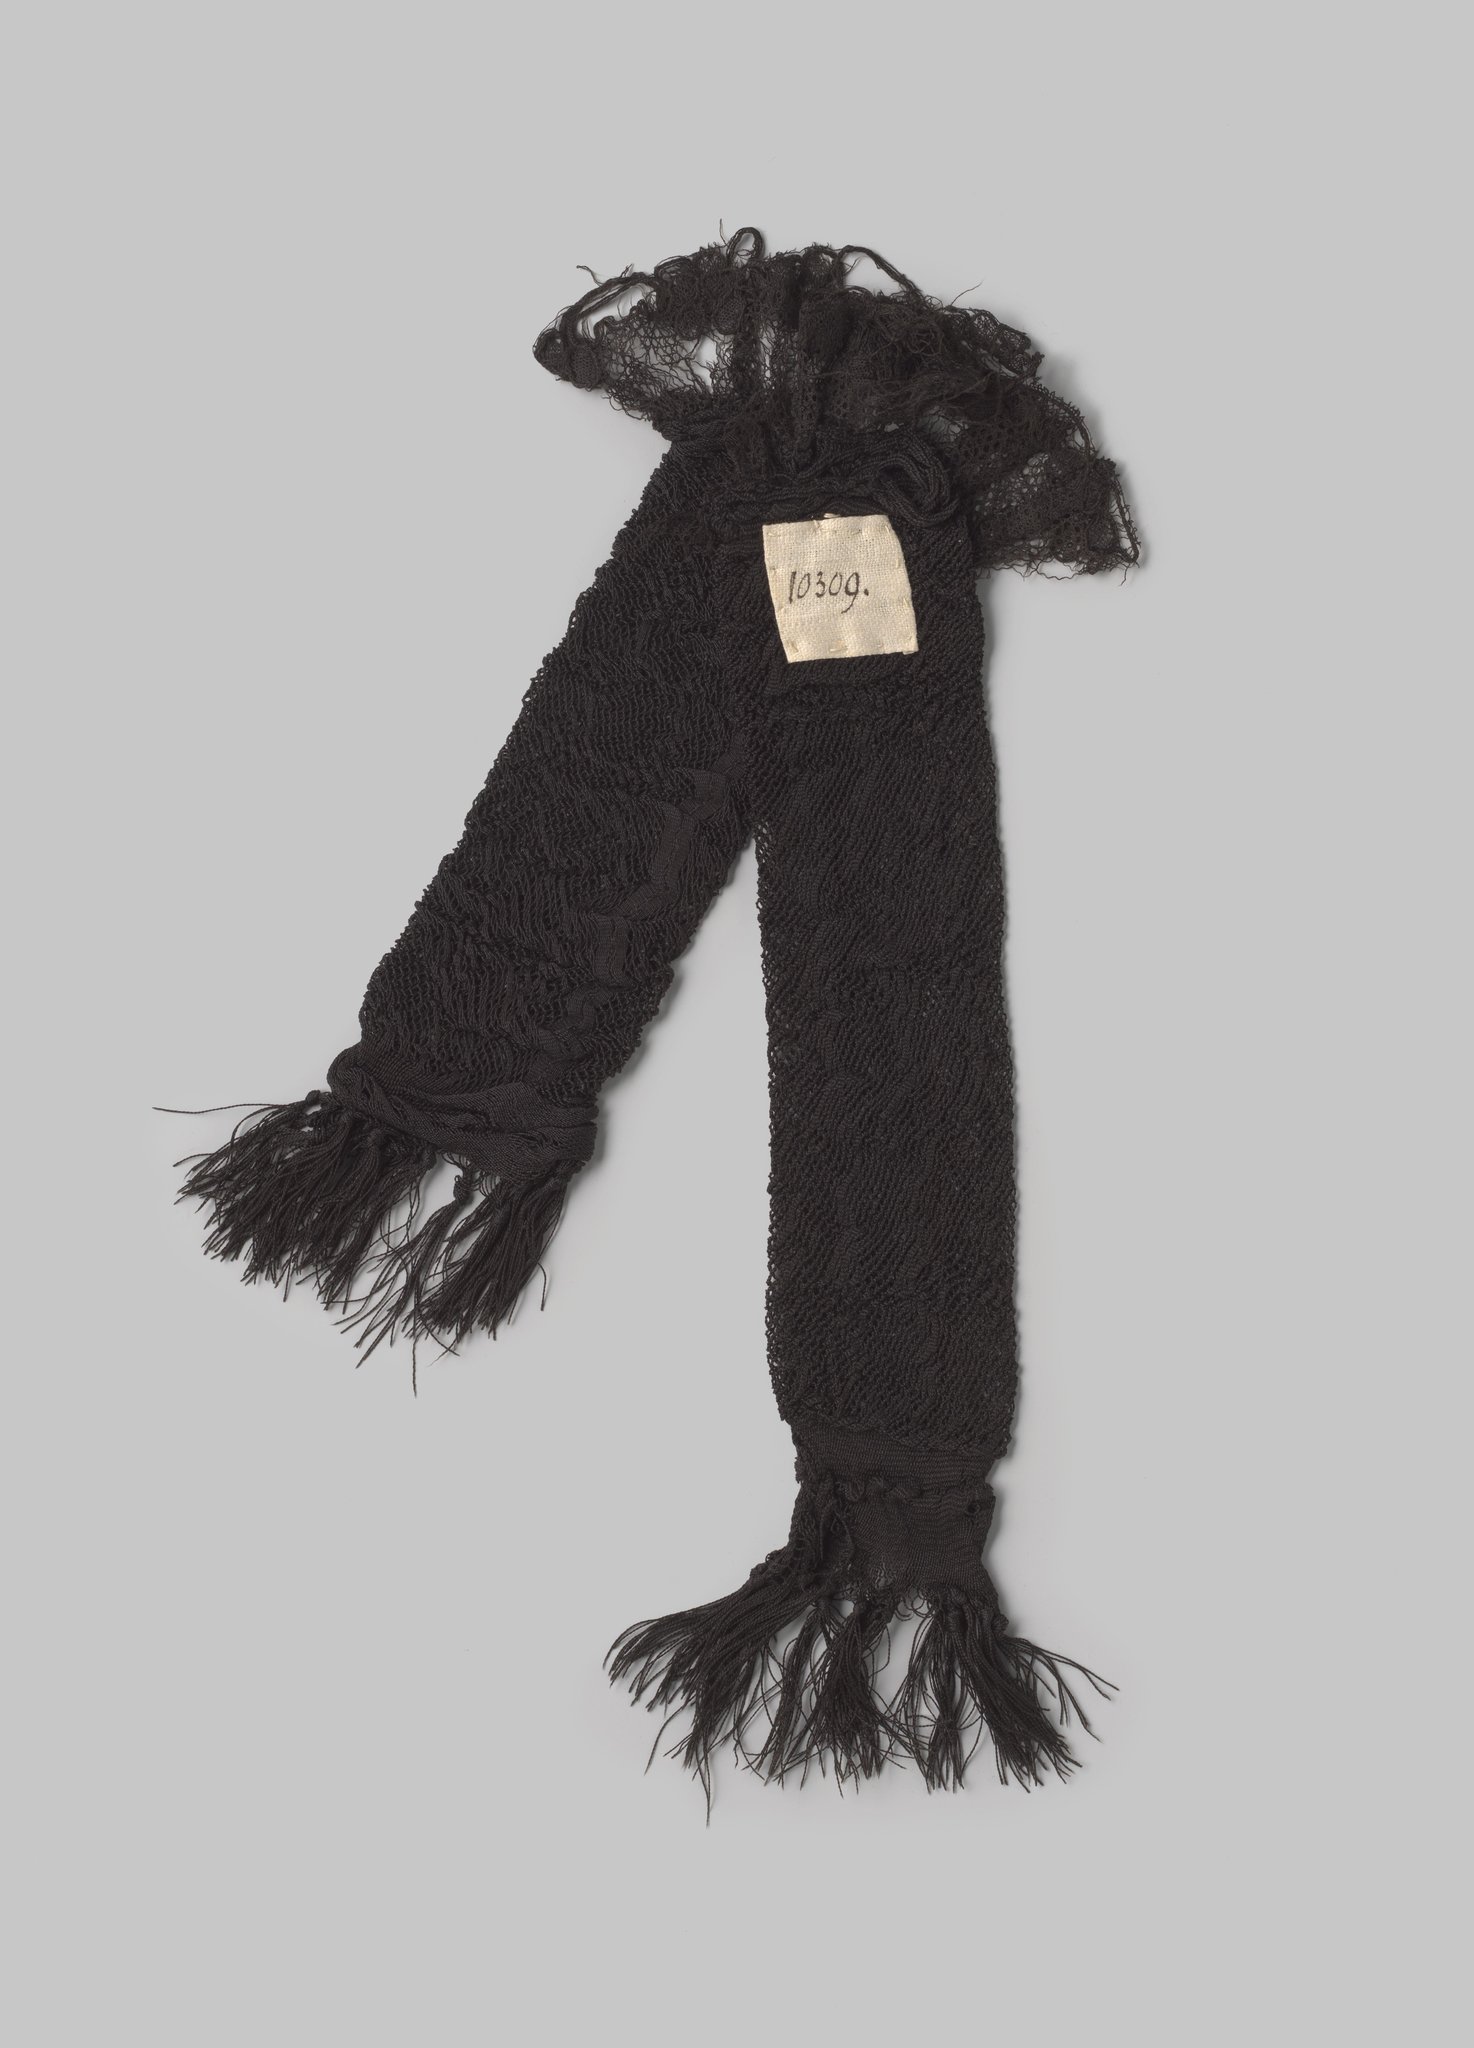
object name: clothing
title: Mitaine van zwarte zijde met franje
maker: Anonymous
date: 1850-1875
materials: silk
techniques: sprang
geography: western europe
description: Mitaine van zwarte zijde met franje in Epyptisch vlechtwerk. Afgezet met zwart kanten rand.